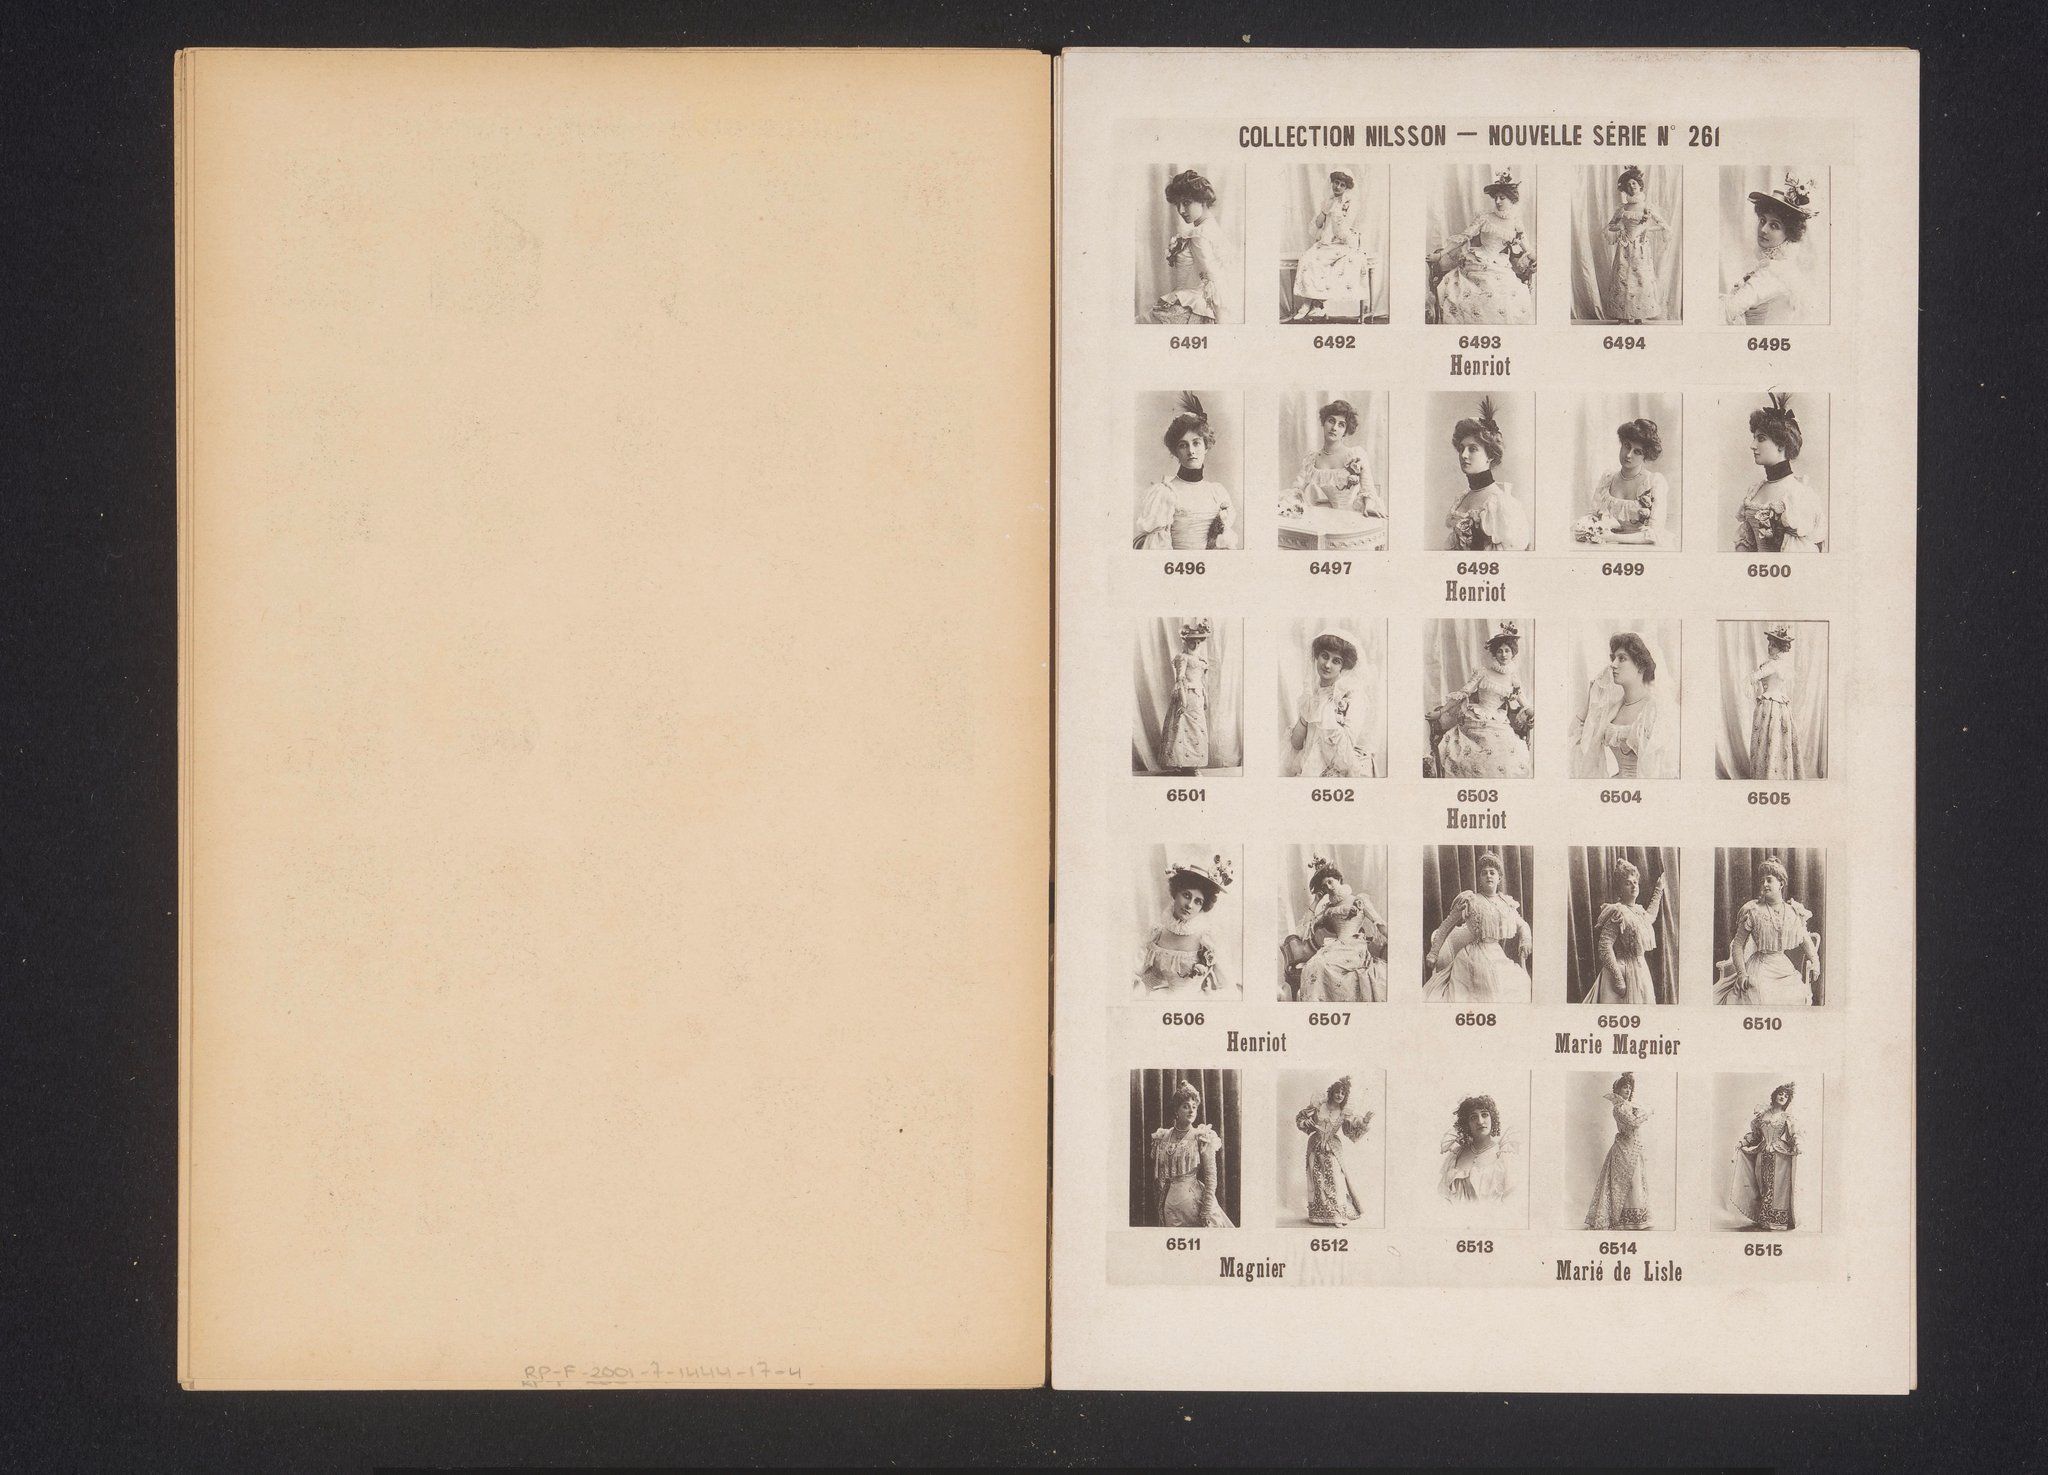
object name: page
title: 25 portretten van Henriot, Marie Magnier en Marié de Lisle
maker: Anonymous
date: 1894-1899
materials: paper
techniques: photograph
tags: historical persons - bb - woman, portrait of actor, actress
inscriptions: number: ‘No 261’